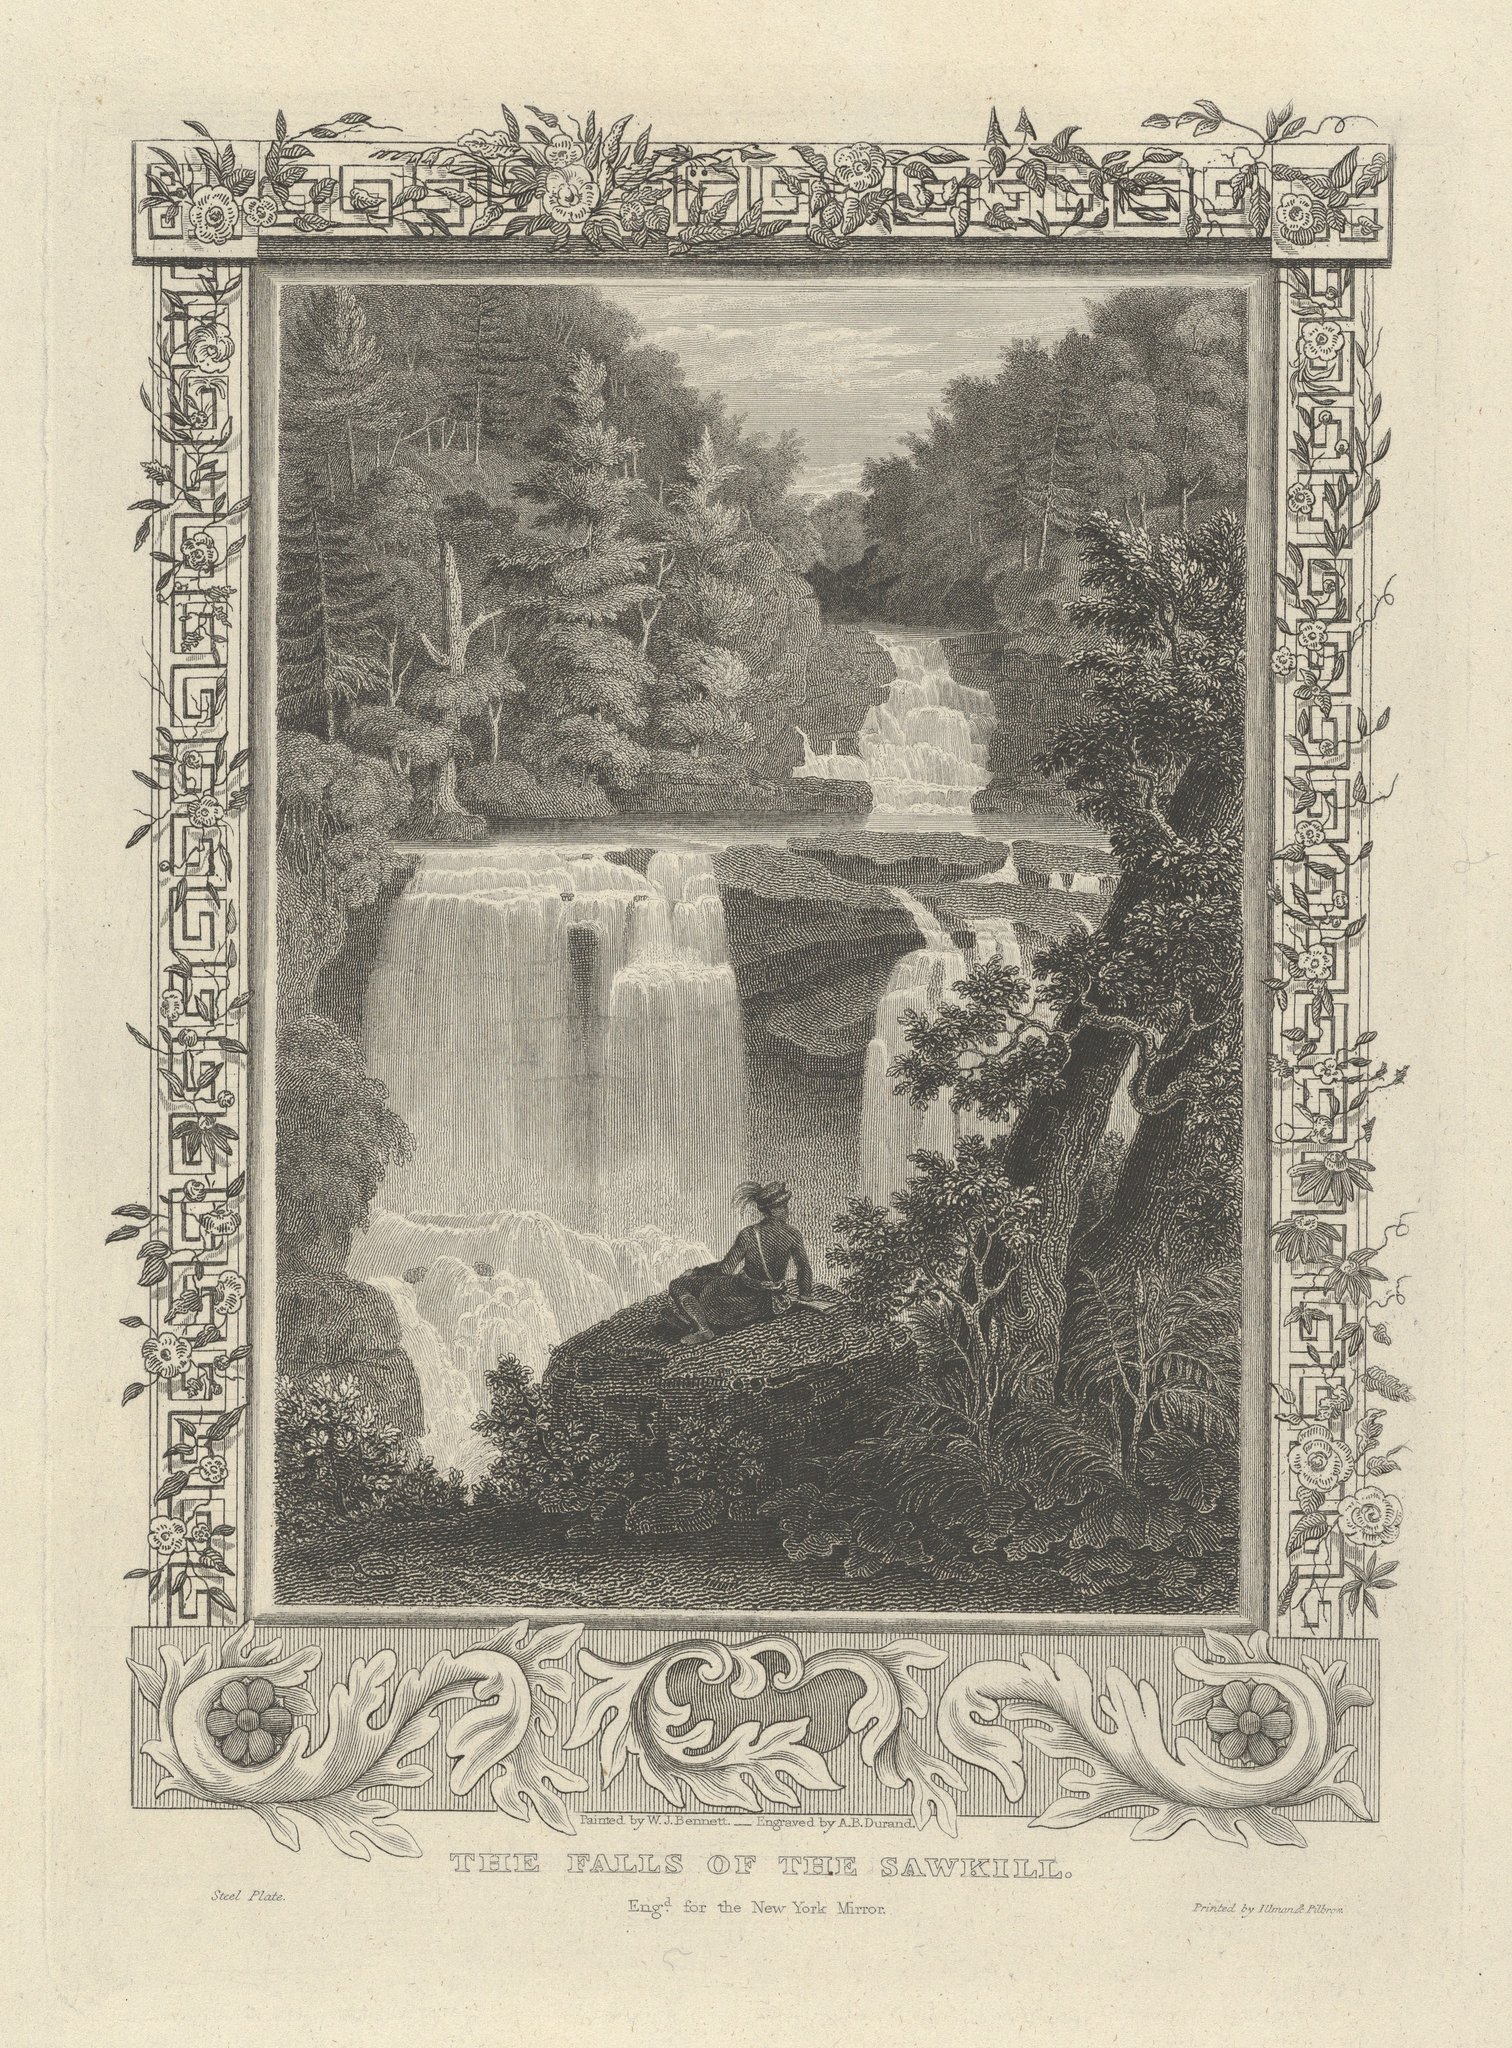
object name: print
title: The Falls of the Sawkill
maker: asher brown durand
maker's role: artist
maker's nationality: american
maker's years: 1796-1886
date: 1830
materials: steel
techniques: engraving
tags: waterfalls